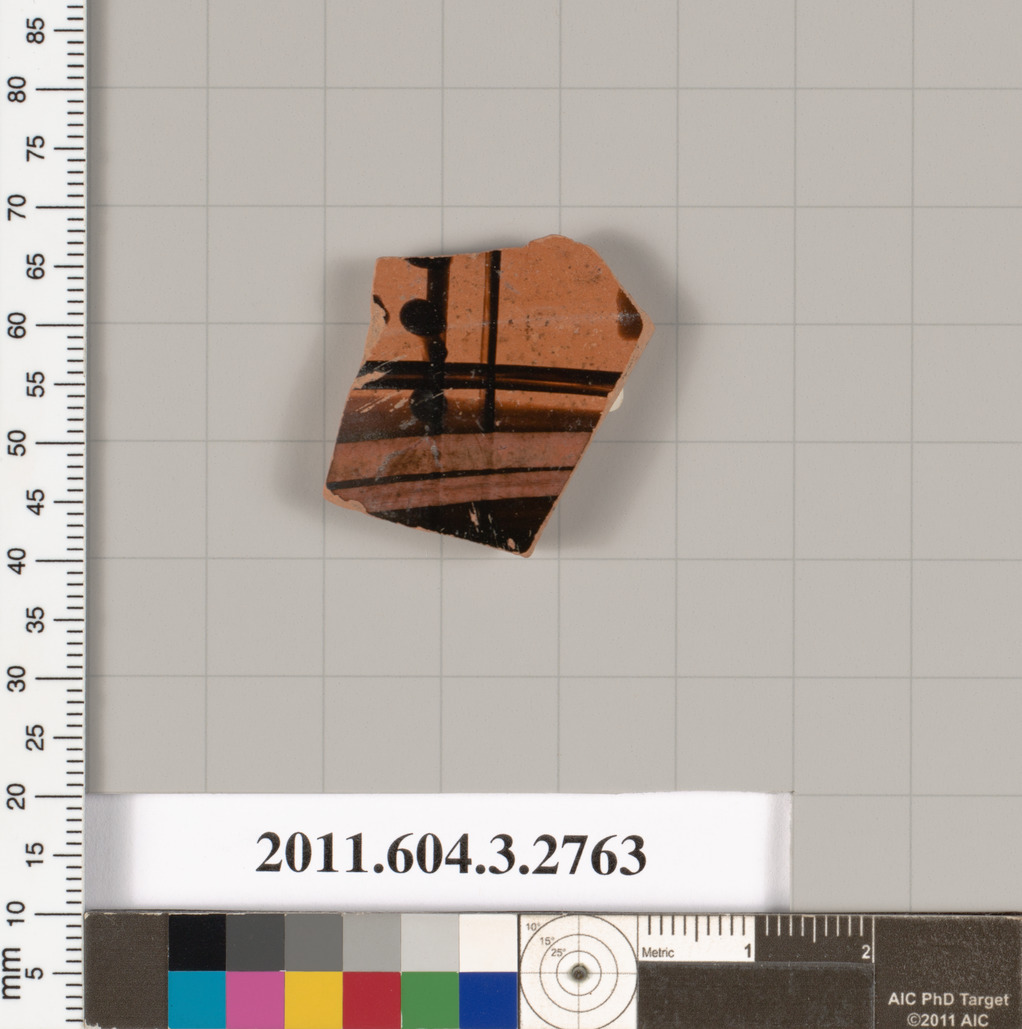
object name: oinochoe fragment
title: Terracotta fragment of an oinochoe (jug)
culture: greek, attic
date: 534-468 BCE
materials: terracotta